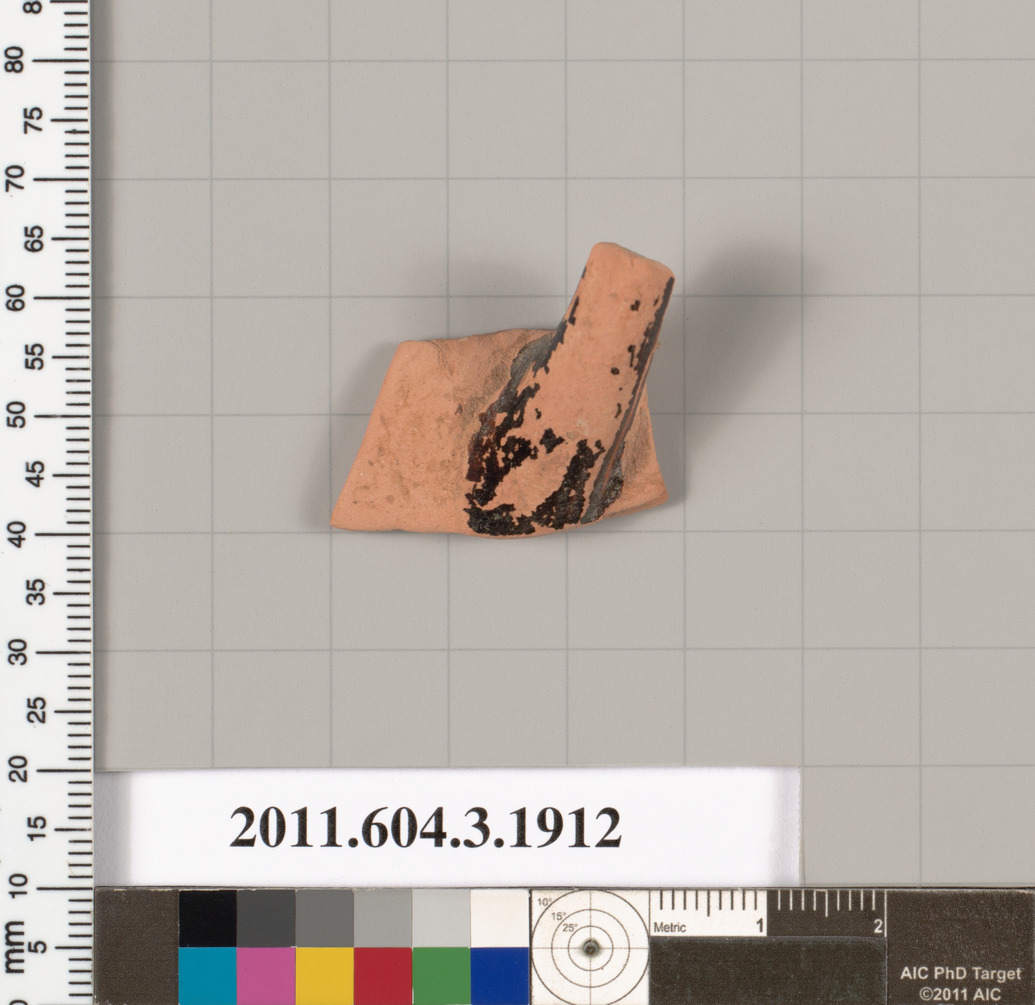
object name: kylix or skyphos fragment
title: Terracotta fragment of a kylix (drinking cup) or a skyphos (deep drinking cup)?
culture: greek, attic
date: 534-468 BCE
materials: terracotta